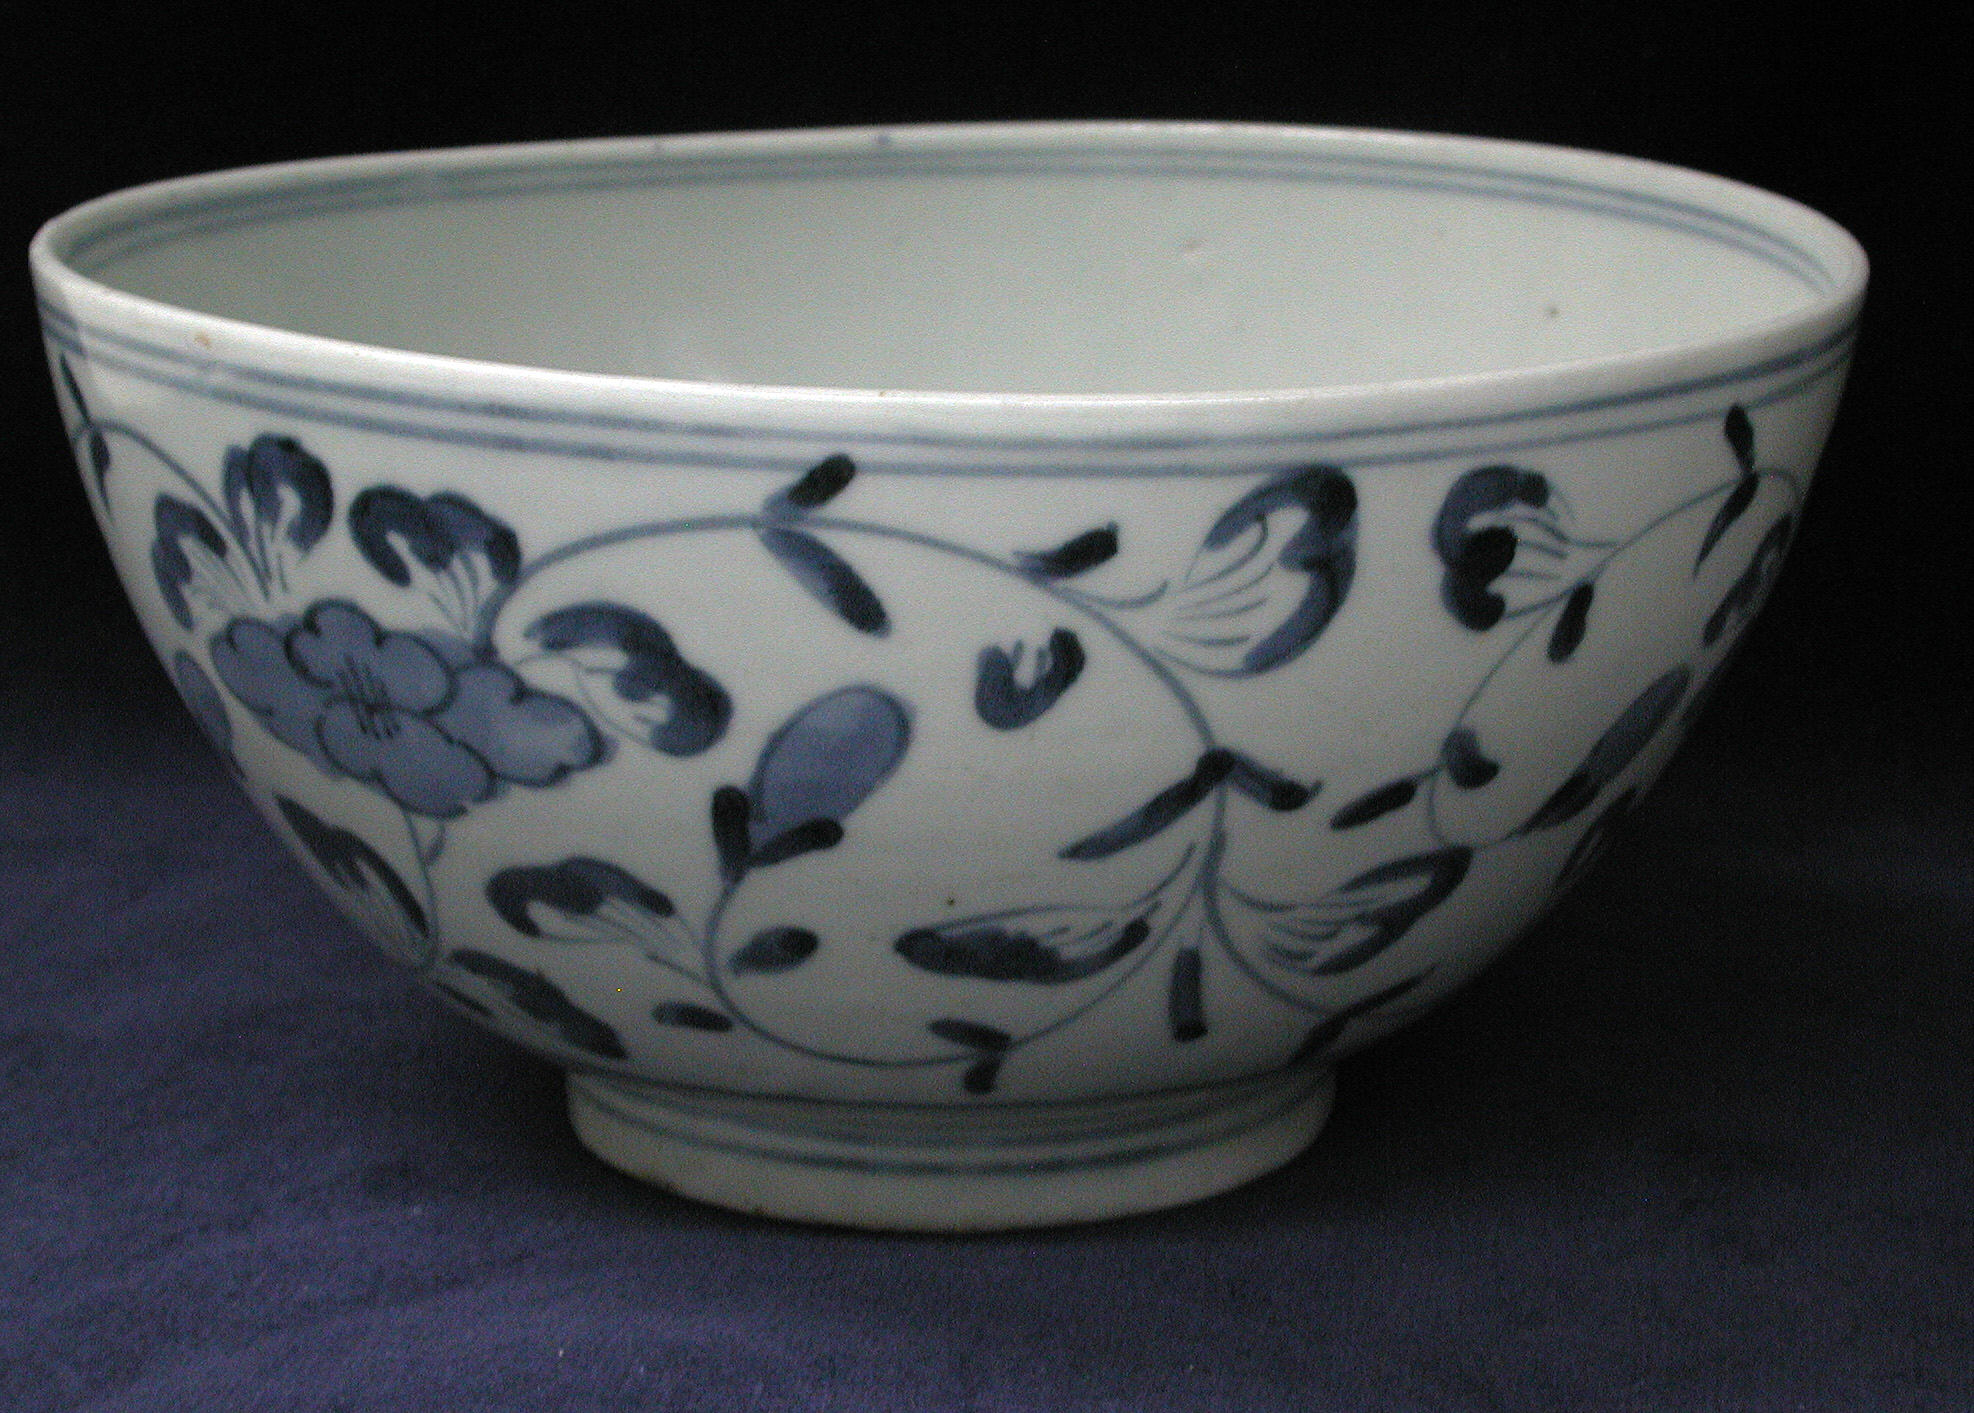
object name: bowl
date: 1700-1720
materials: hard paste porcelain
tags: flowers